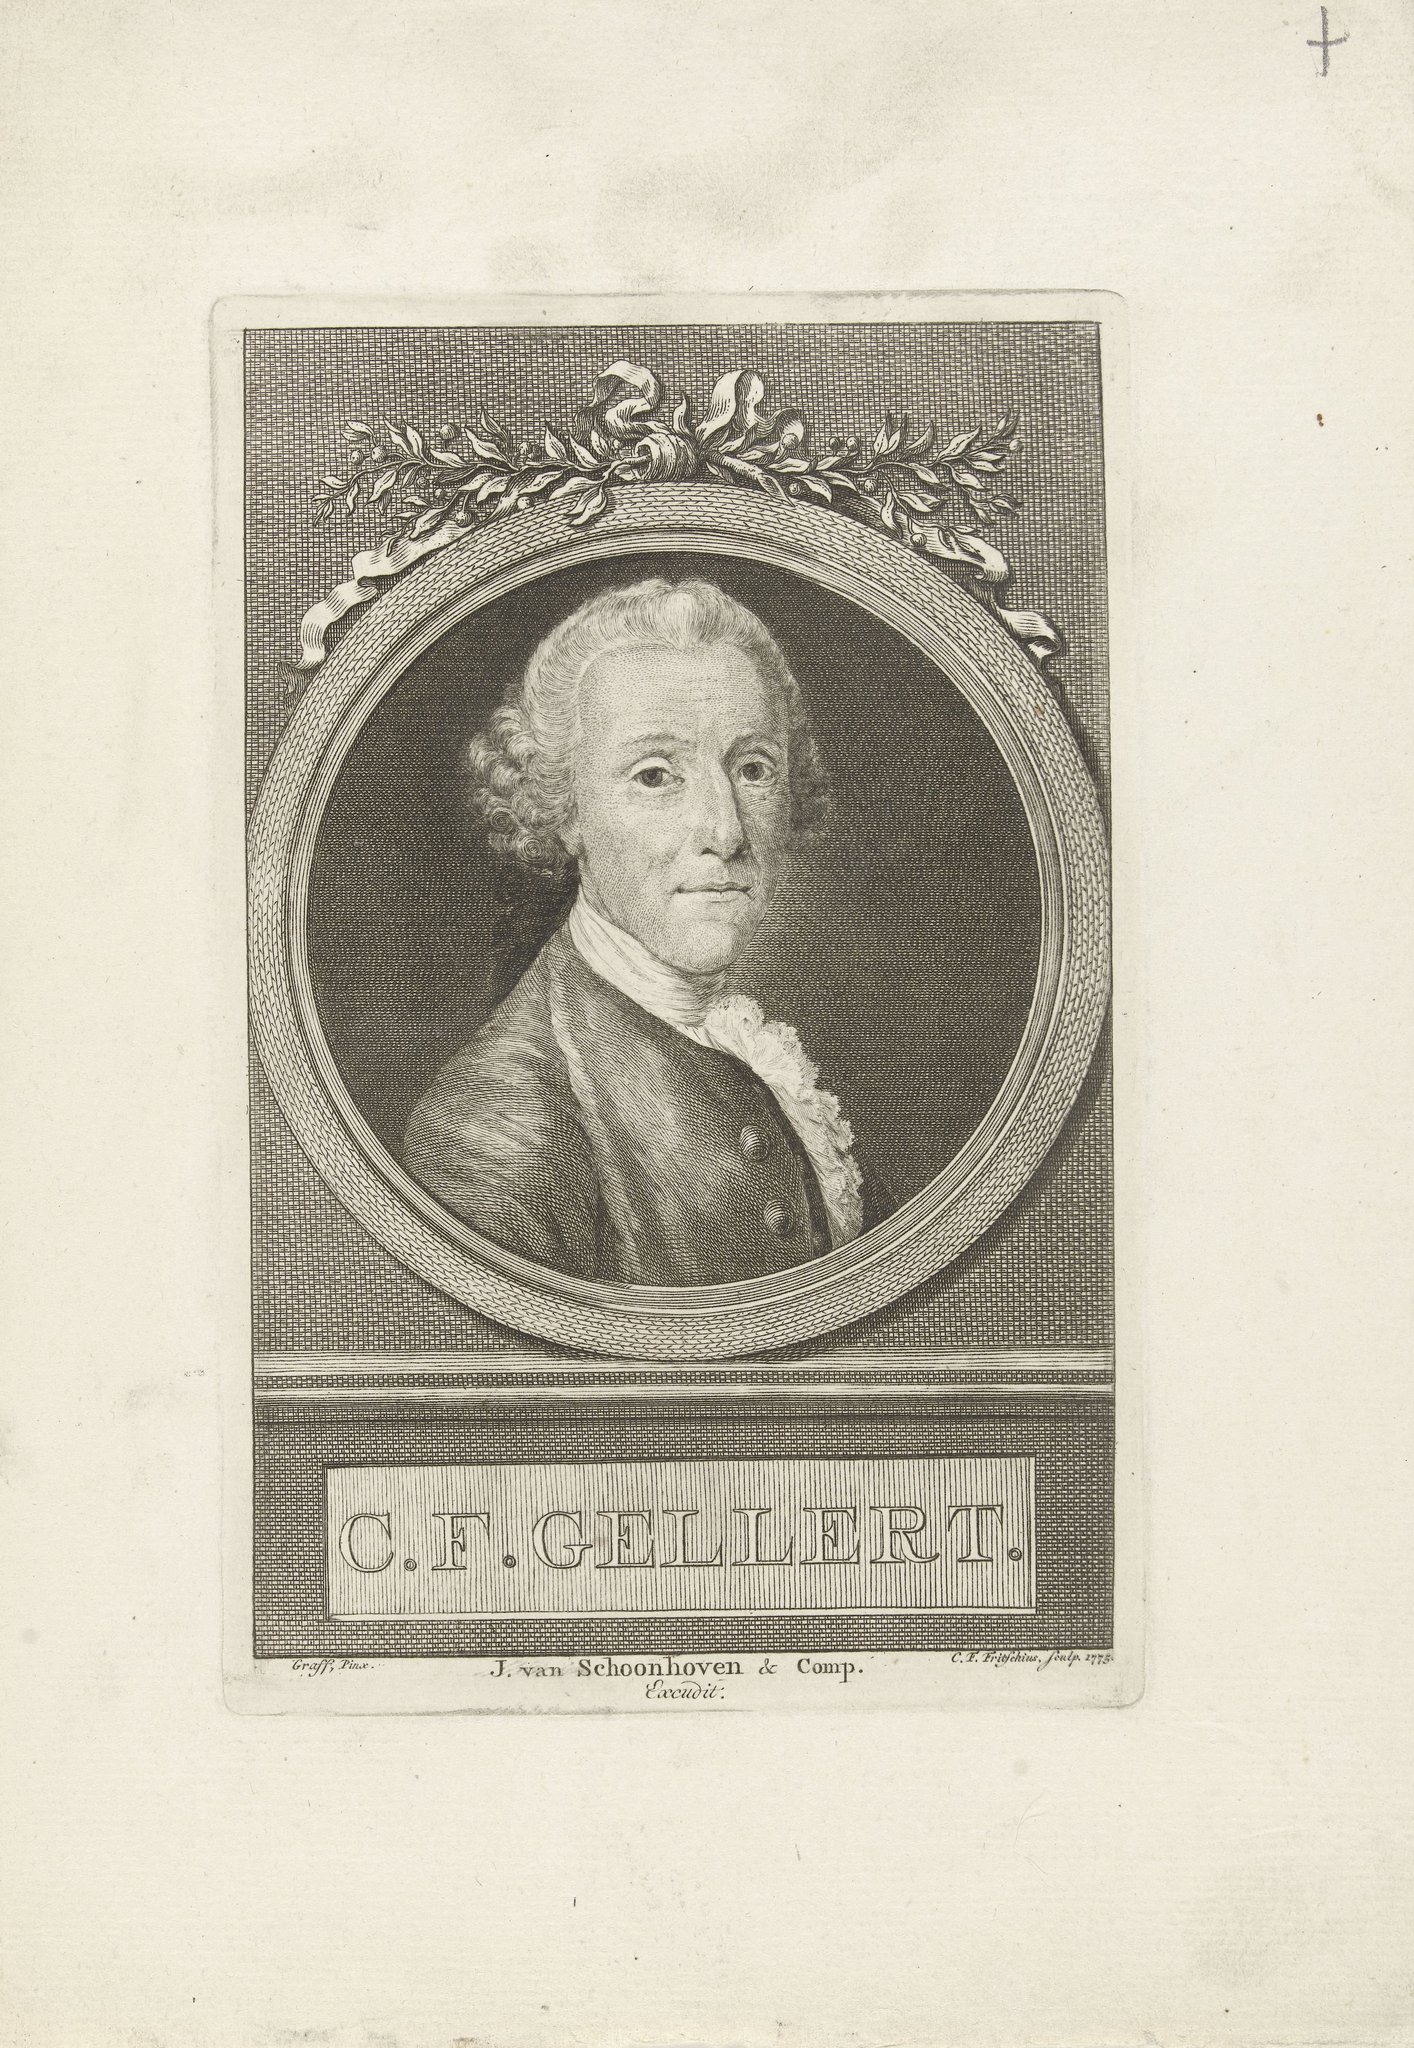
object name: print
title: Portret van Christian Furchtegott Gellert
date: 1775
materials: paper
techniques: engraving, etching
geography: utrecht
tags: saksen, leipzig, filosoof, dichter, schrijver, christian fürchtegott gellert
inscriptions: collector's mark: Lugt 2228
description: Medaillonportret van de auteur Christian Furchtegott Gellert. Het medaillon is bovenaan versierd met olijftakken en linten. Onder het medaillon staat de naam van de geportretteerde.